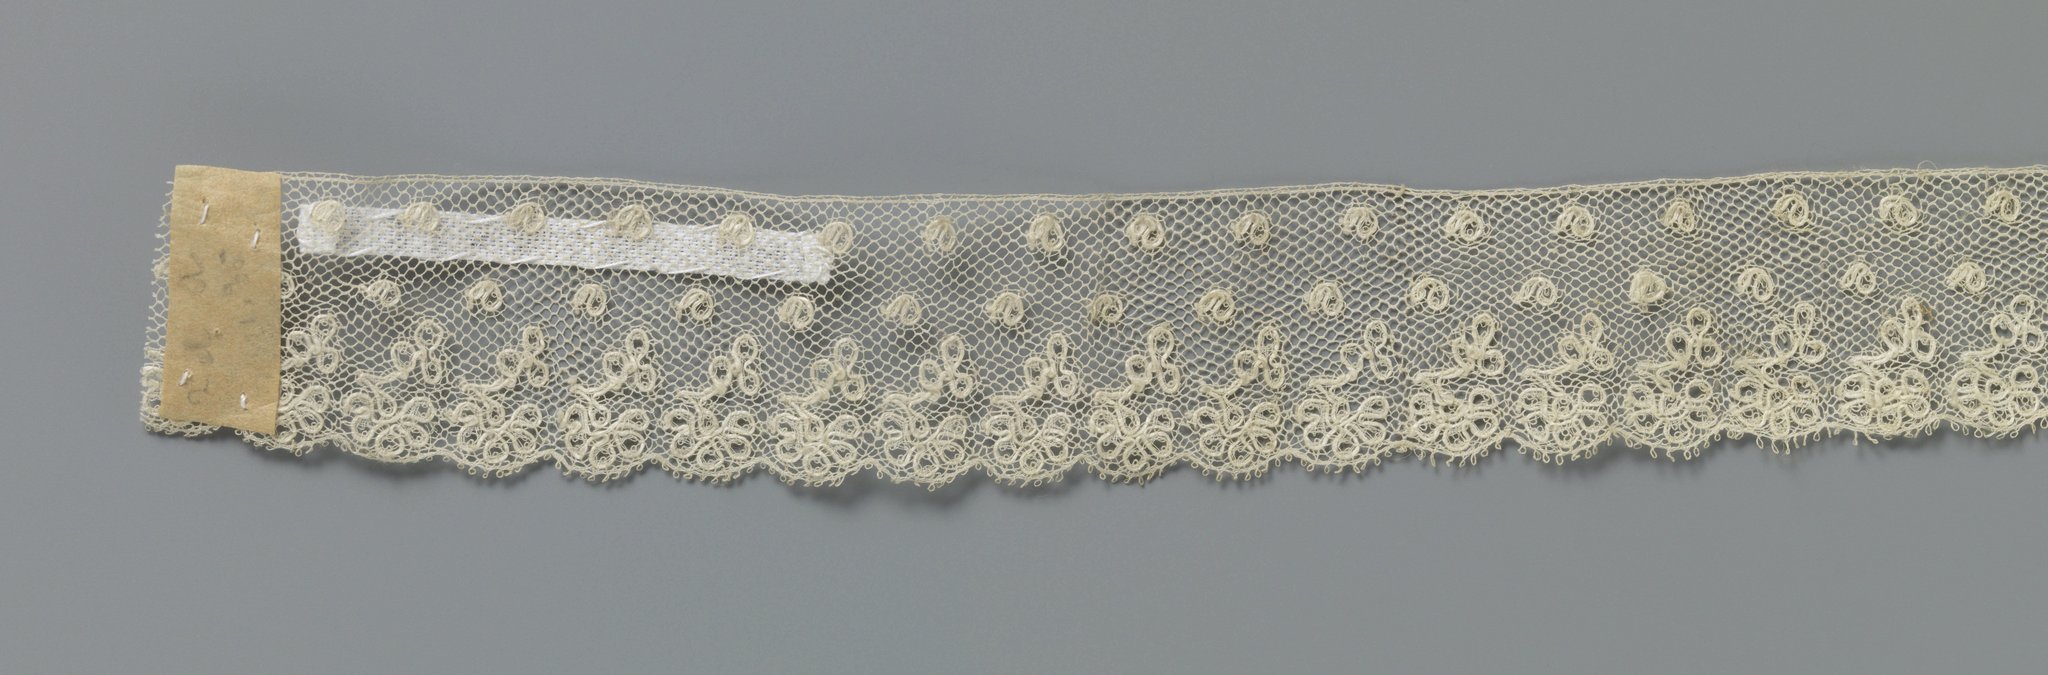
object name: strip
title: Strook kloskant met roosmotief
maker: Anonymous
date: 1795-1805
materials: linen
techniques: lace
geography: southern netherlands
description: Strook naturelkleurige kloskant: Mechelse kant. Onder een strooipatroon van dubbele blaadjes staat langs de onderzijde van de strook een zich herhalend patroon van een hangend rozentakje. De bloem heeft aan één kant van het bloemhart vijf bloemblaadjes. Elke bloem hangt in een halfrond schulpje. Een kort takje met een drievoudig blaadje is omhoog gericht. De motieven zijn met elkaar verbonden door een fijne maasgrond, een Mechelse grond. De motieven zijn voornamelijk gemaakt door afwijkende openingen in de maasgrond, met dikkere en glimmende contourdraden er omheen gewerkt. Er is zeer spaarzaam linnenslag gebruikt in de motieven, versierd met lusjes. De bovenzijde van de strook is recht afgewerkt. De schulpenrand langs de onderzijde van de strook is afgewerkt met picots.